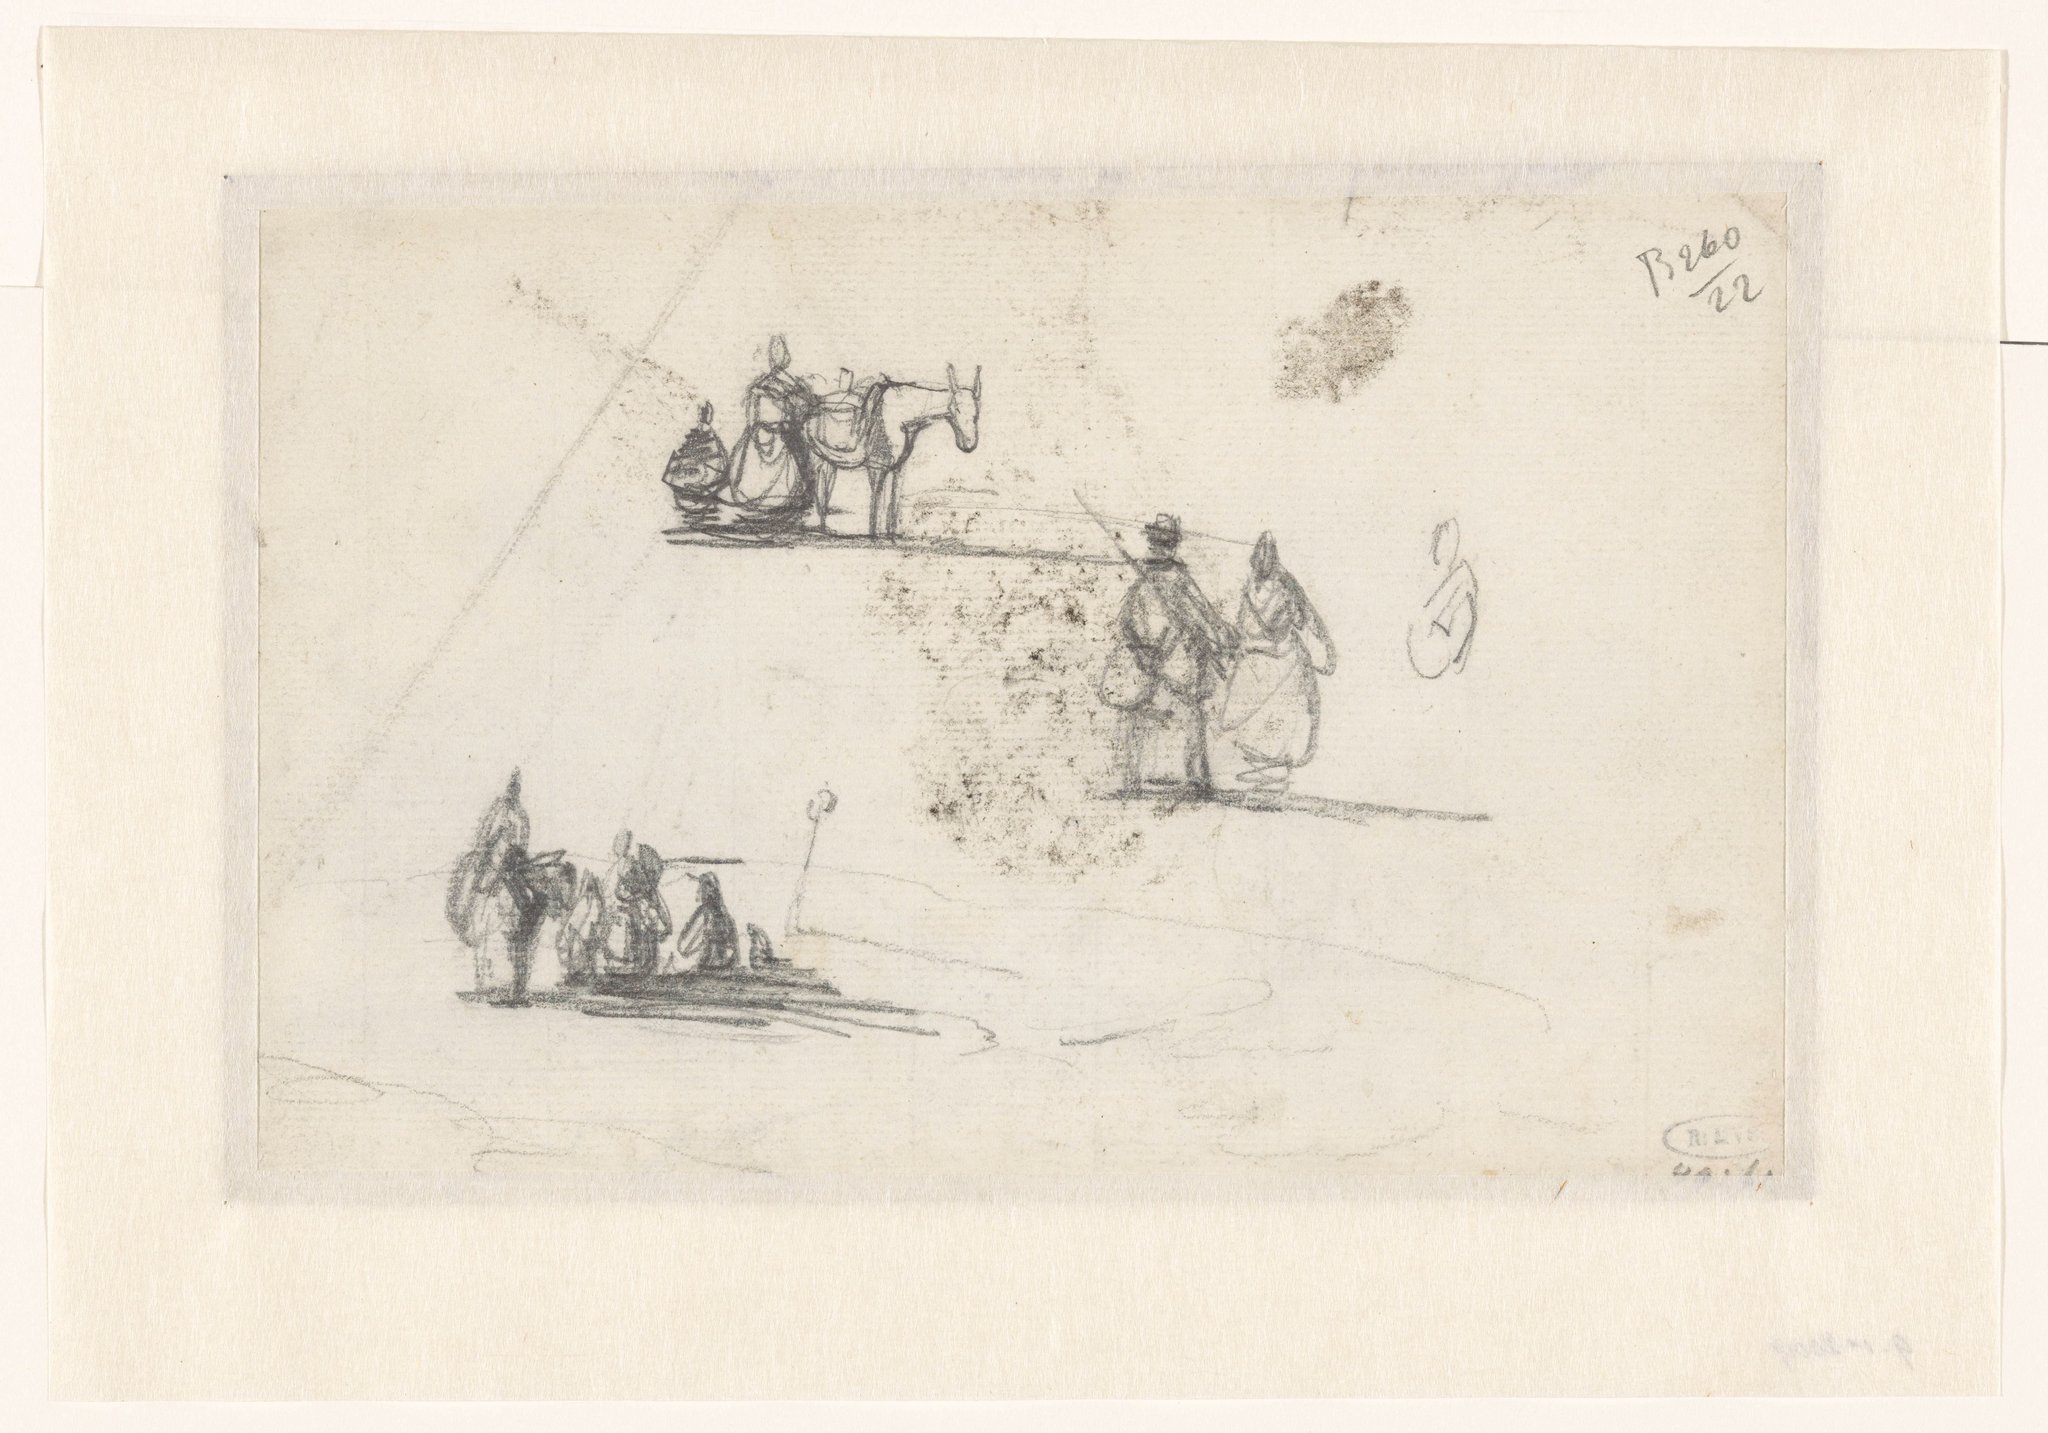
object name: drawing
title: Schetsblad met studies van figuren en een ezel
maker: andreas schelfhout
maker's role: draughtsman, painter, print maker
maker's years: 1787-1870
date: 1797-1870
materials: paper, pencil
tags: ass, donkey